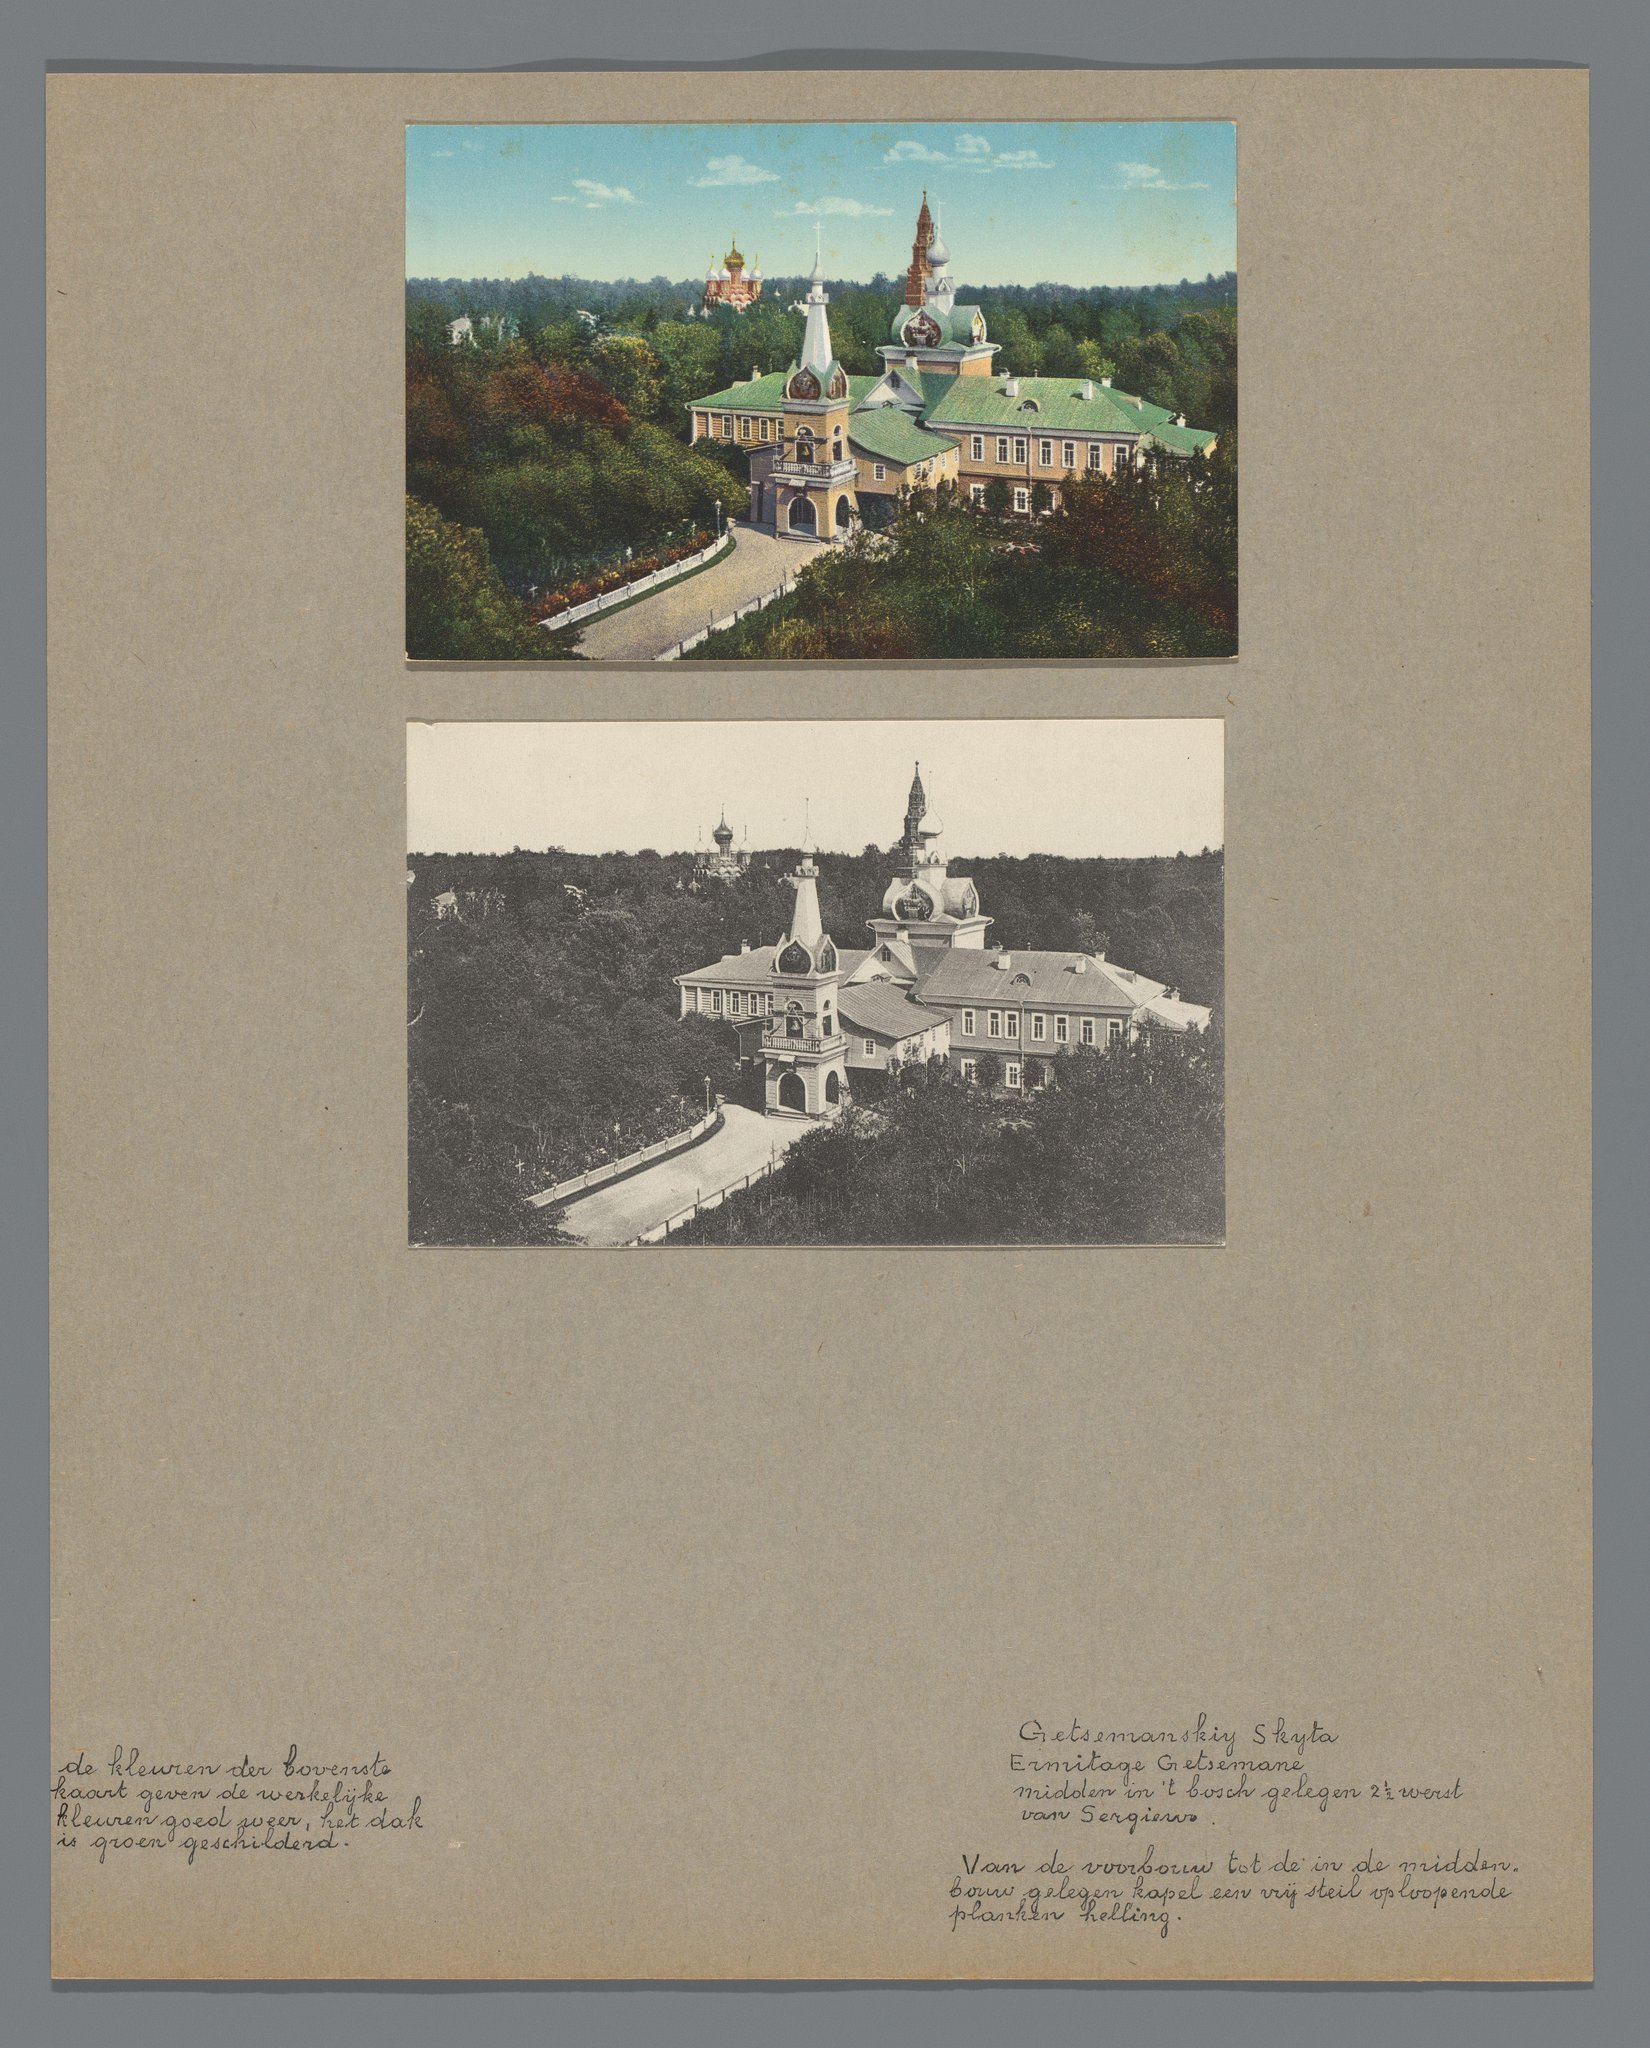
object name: photograph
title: Getsemanskiy Skyta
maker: Anonymous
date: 1860-1925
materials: photographic support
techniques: photograph, lithograph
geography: russia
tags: russia